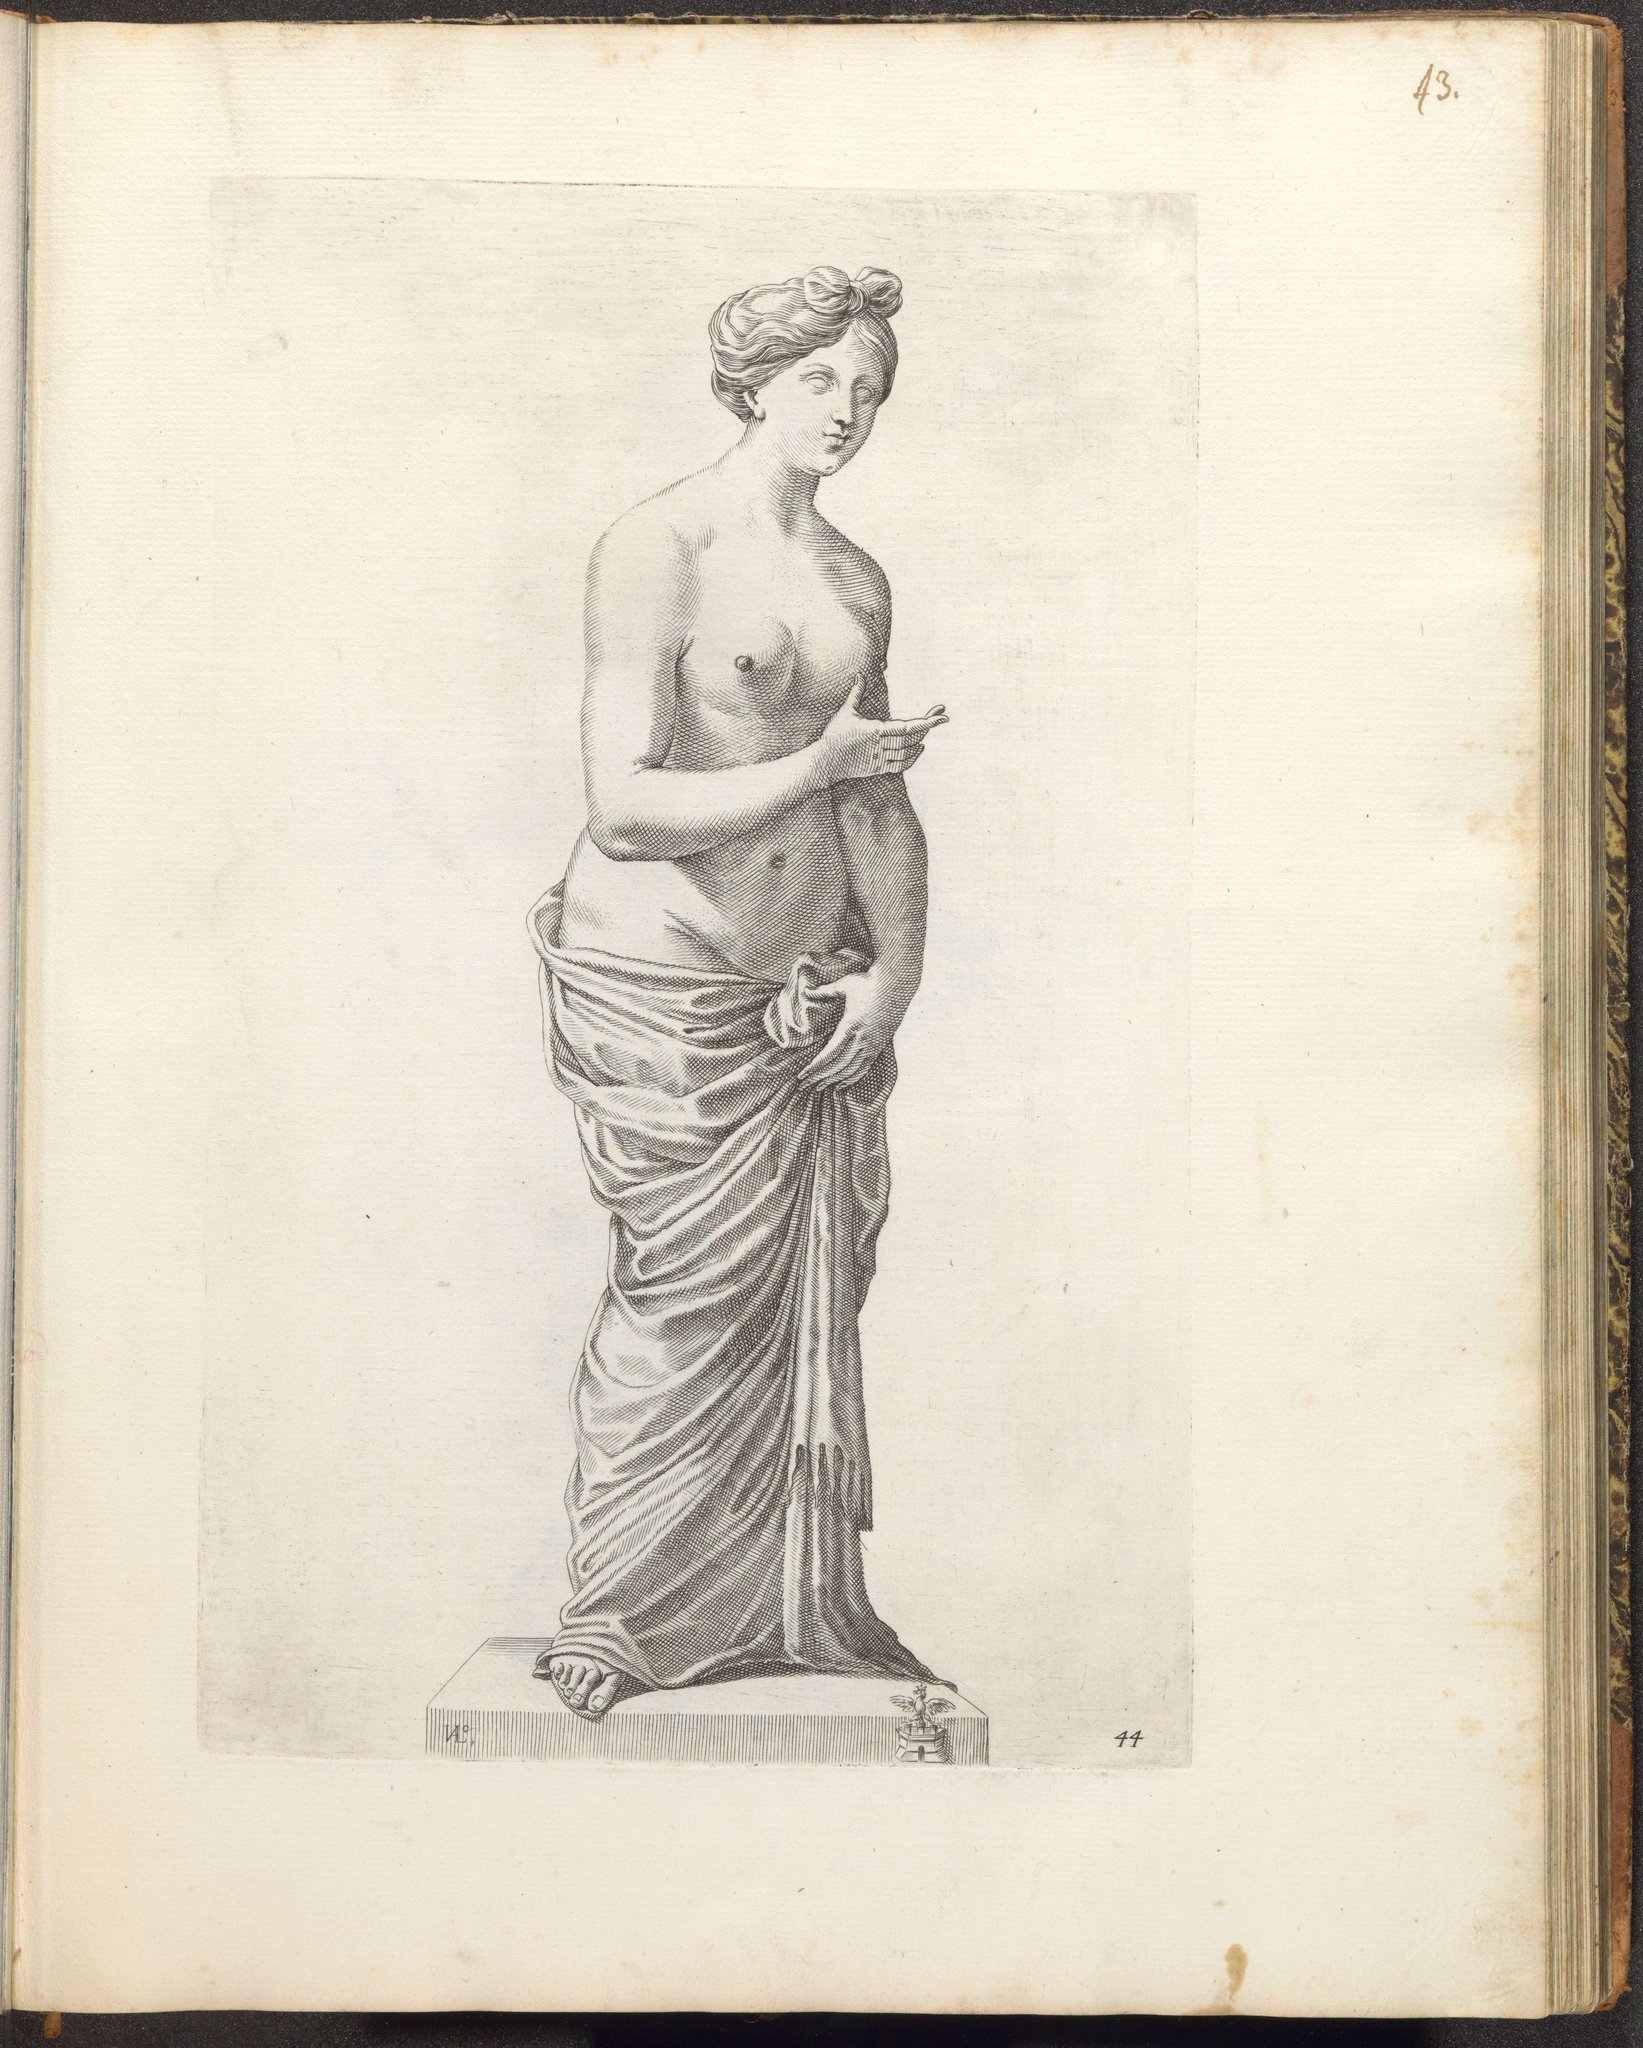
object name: print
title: Galleria Giustiniana del Marchese Vincenzo Giustiniani I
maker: giovanni luigi valesio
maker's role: print maker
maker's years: 1583-1633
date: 1636-1647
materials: paper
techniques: engraving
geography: rome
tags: piece of sculpture, reproduction of a piece of sculpture, (story of) venus (aphrodite)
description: Standbeeld van Venus, staande, haar draperieën bij elkaar houdend. Op de basis het wapenschild van Vincenzo Giustiniani. Prent maakt deel uit van een album met een serie prenten naar de sculpturen in de verzameling in de Galleria Giustiniani te Rome.